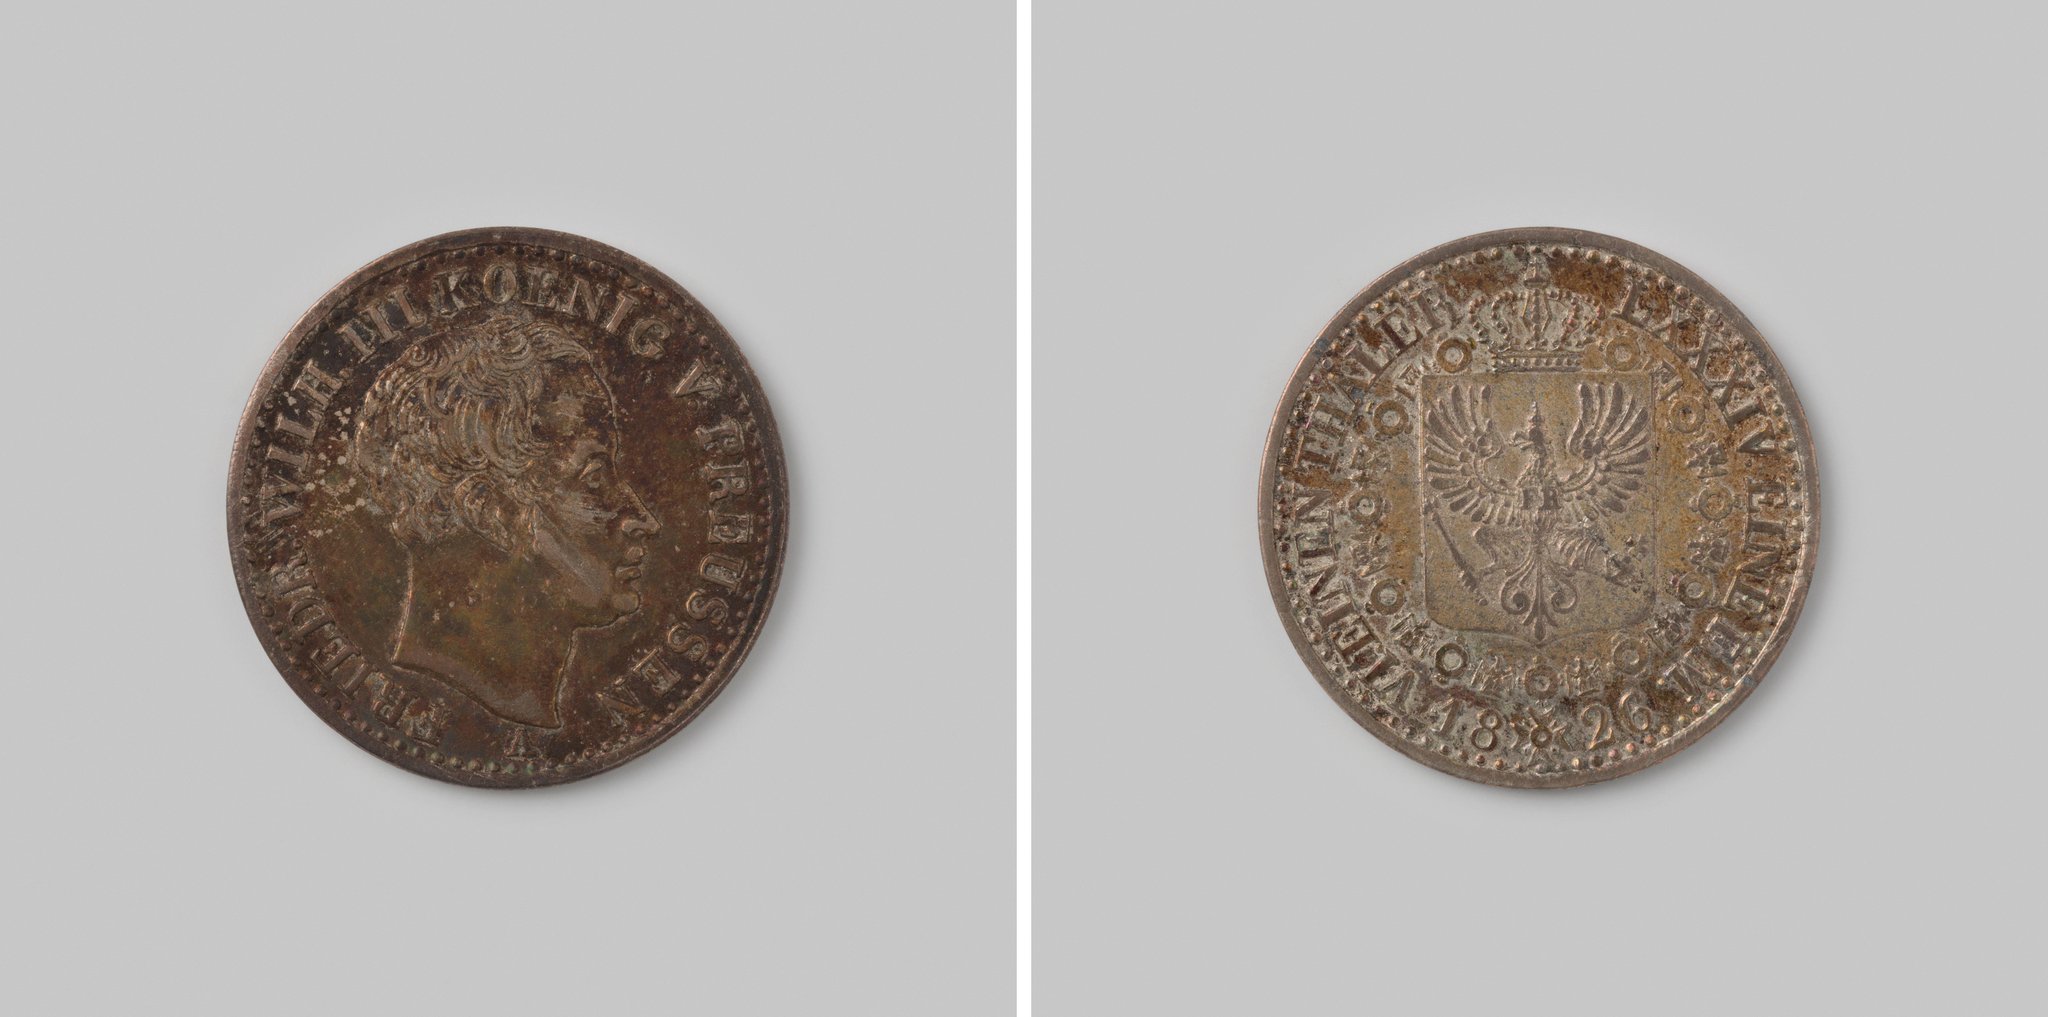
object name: zesde taler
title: Pruisen, Friedrich Wilhelm III, 1/6 Taler, 1826 A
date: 1826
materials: silver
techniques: striking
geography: berlin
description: Zilveren munt. Voorzijde: hoofd van de koning naar rechts. Daaronder letter A. Keerzijde: door keten en juweel van ridderorde omhangen gekroond wapenschild. In omschrift waarde-anduiding: VI einen Thaler en jaartal onderaan. Randschrift.